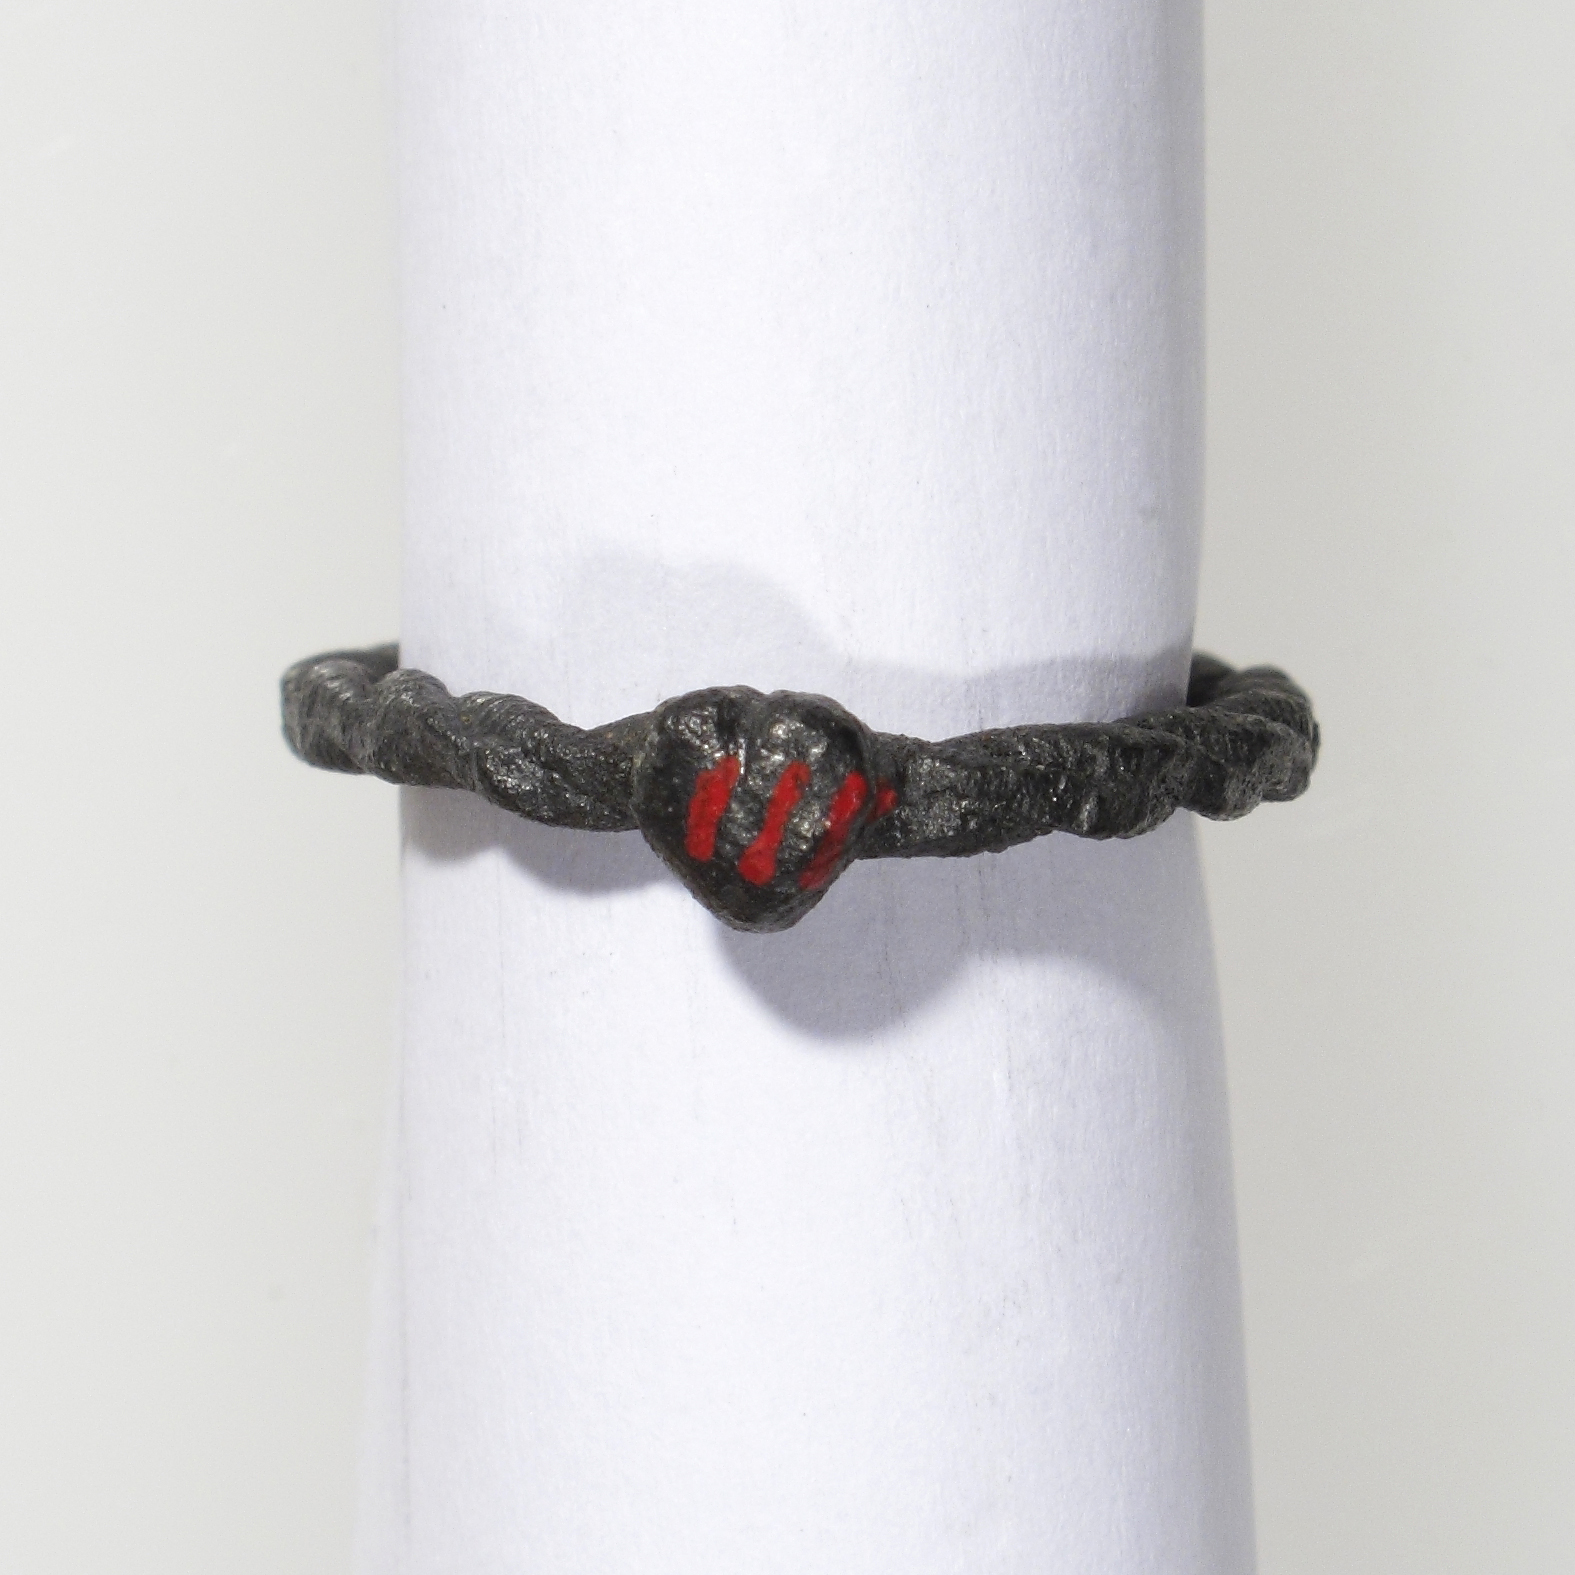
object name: pilgrim's badge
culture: french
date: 1301-1600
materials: lead